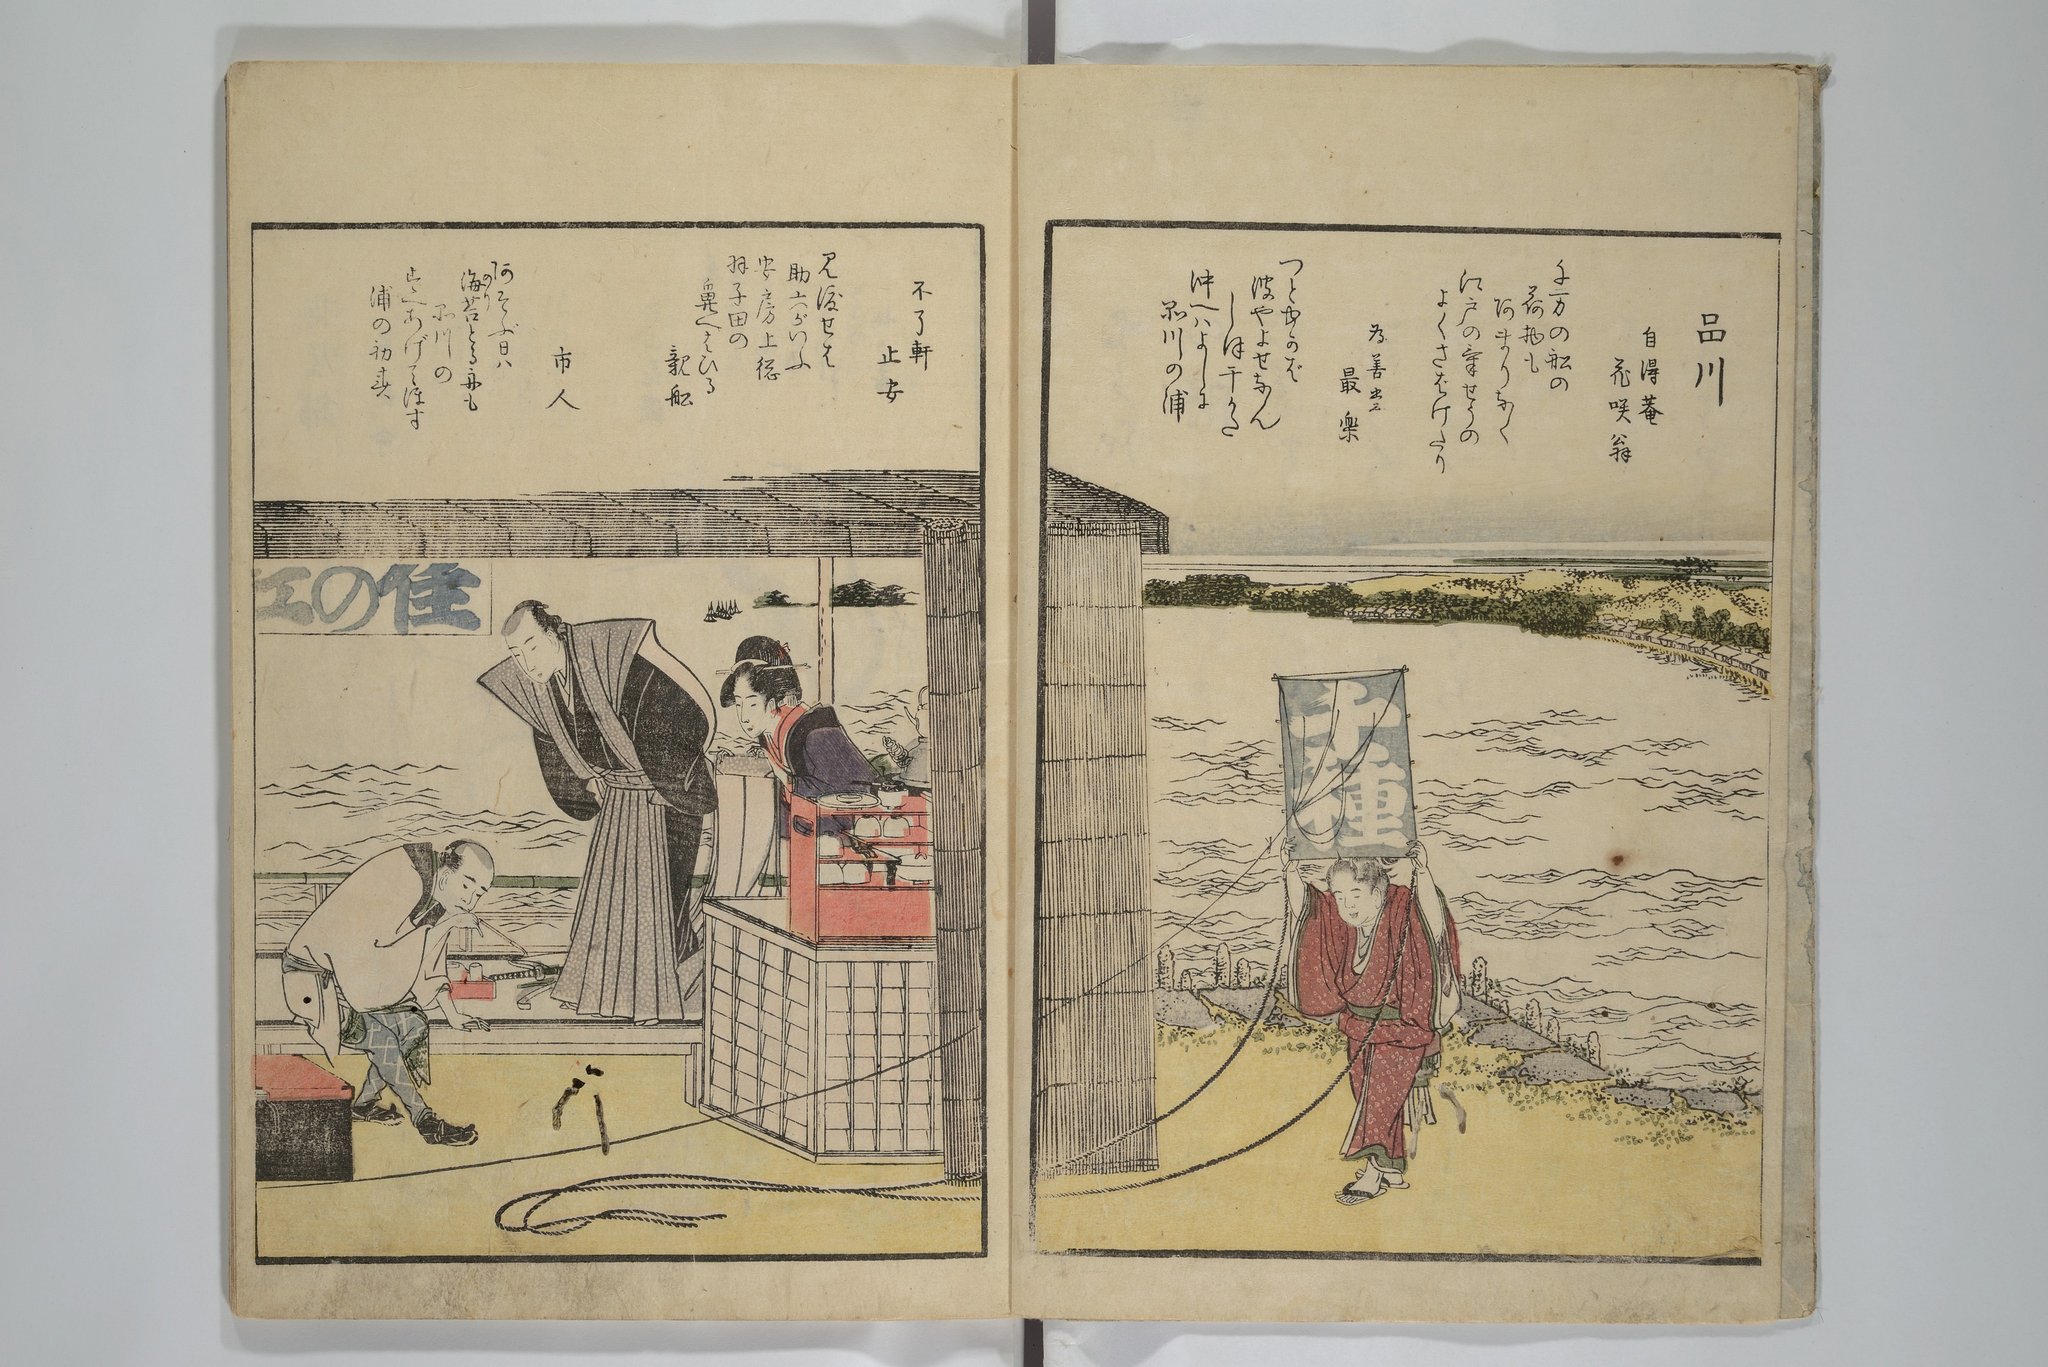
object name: illustrated book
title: Fine Views of the Eastern Capital at a Glance (Tōto meisho ichiran) 東都名所一覧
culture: japanese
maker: katsushika hokusai 葛飾北斎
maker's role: artist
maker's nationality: japanese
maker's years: 1760-1849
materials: ink, paper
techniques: woodblock print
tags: men,women,landscapes,boats,tea houses